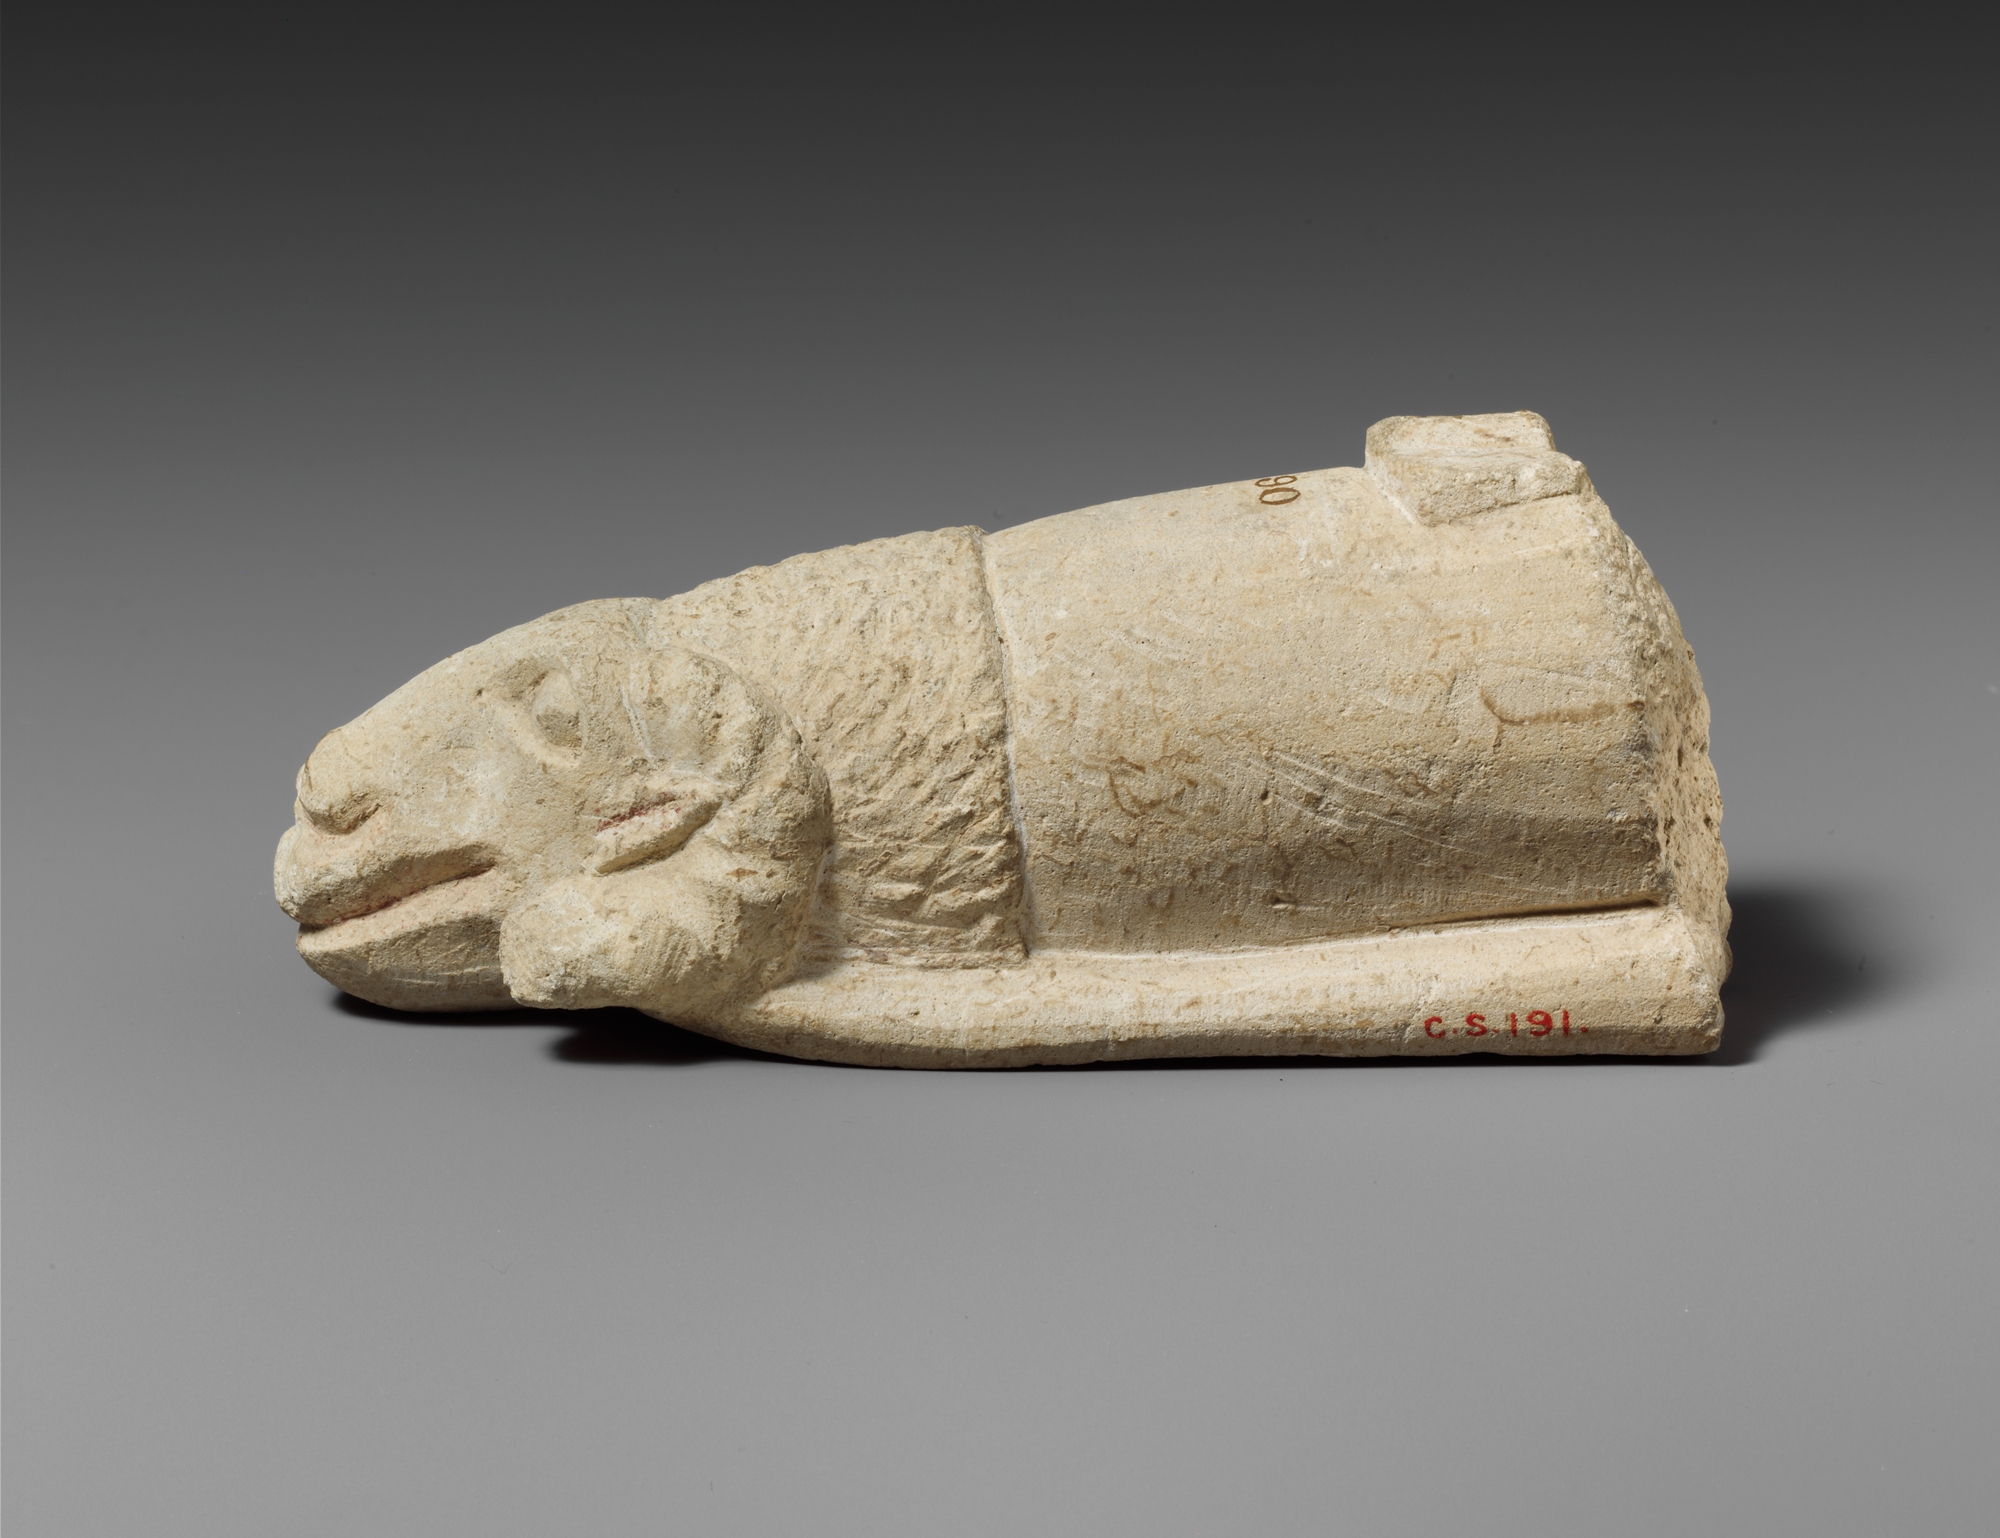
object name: fire shovel handle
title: Limestone handle of a patera or a fire shovel ending in a ram’s head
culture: cypriot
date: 500-401 BCE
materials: limestone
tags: rams